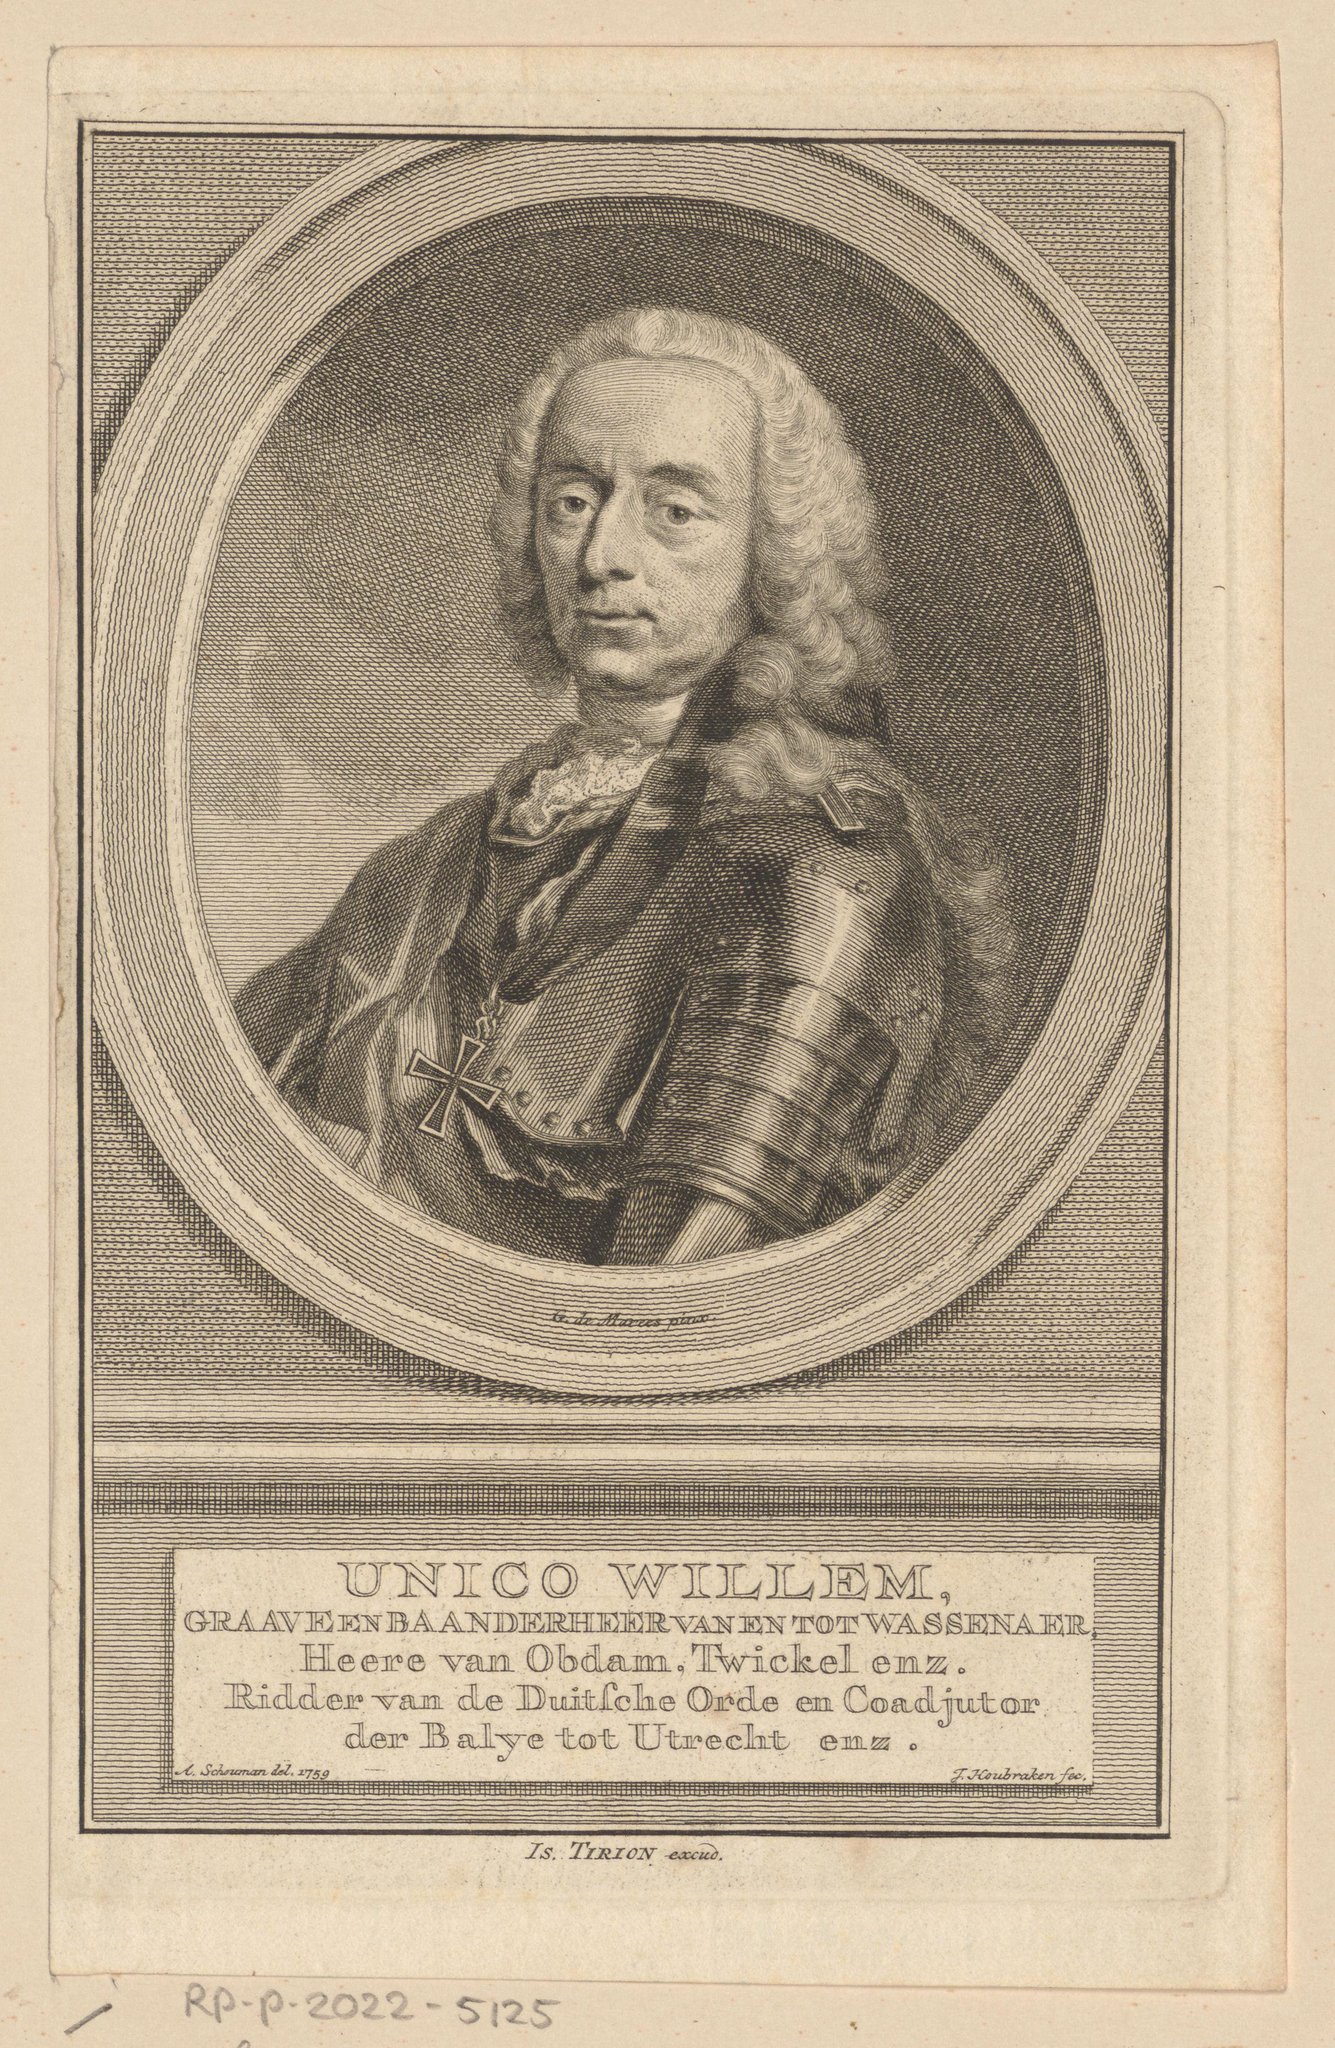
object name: print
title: Portret van Unico Wilhelm van Wassenaer-Obdam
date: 1759-1782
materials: paper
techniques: engraving, etching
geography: amsterdam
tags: armour, historical persons, medals and other marks of military honour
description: Prent waarschijnlijk uit: Jan Wagenaar, Vaderlandsche historie, vervattende de geschiedenissen der nu Vereenigde Nederlanden, inzonderheid die van Holland (...). Amsterdam: Isaak Tirion, 1759, dl. 20. Ook gebruikt in latere edities (1770, 1782) van dit werk.